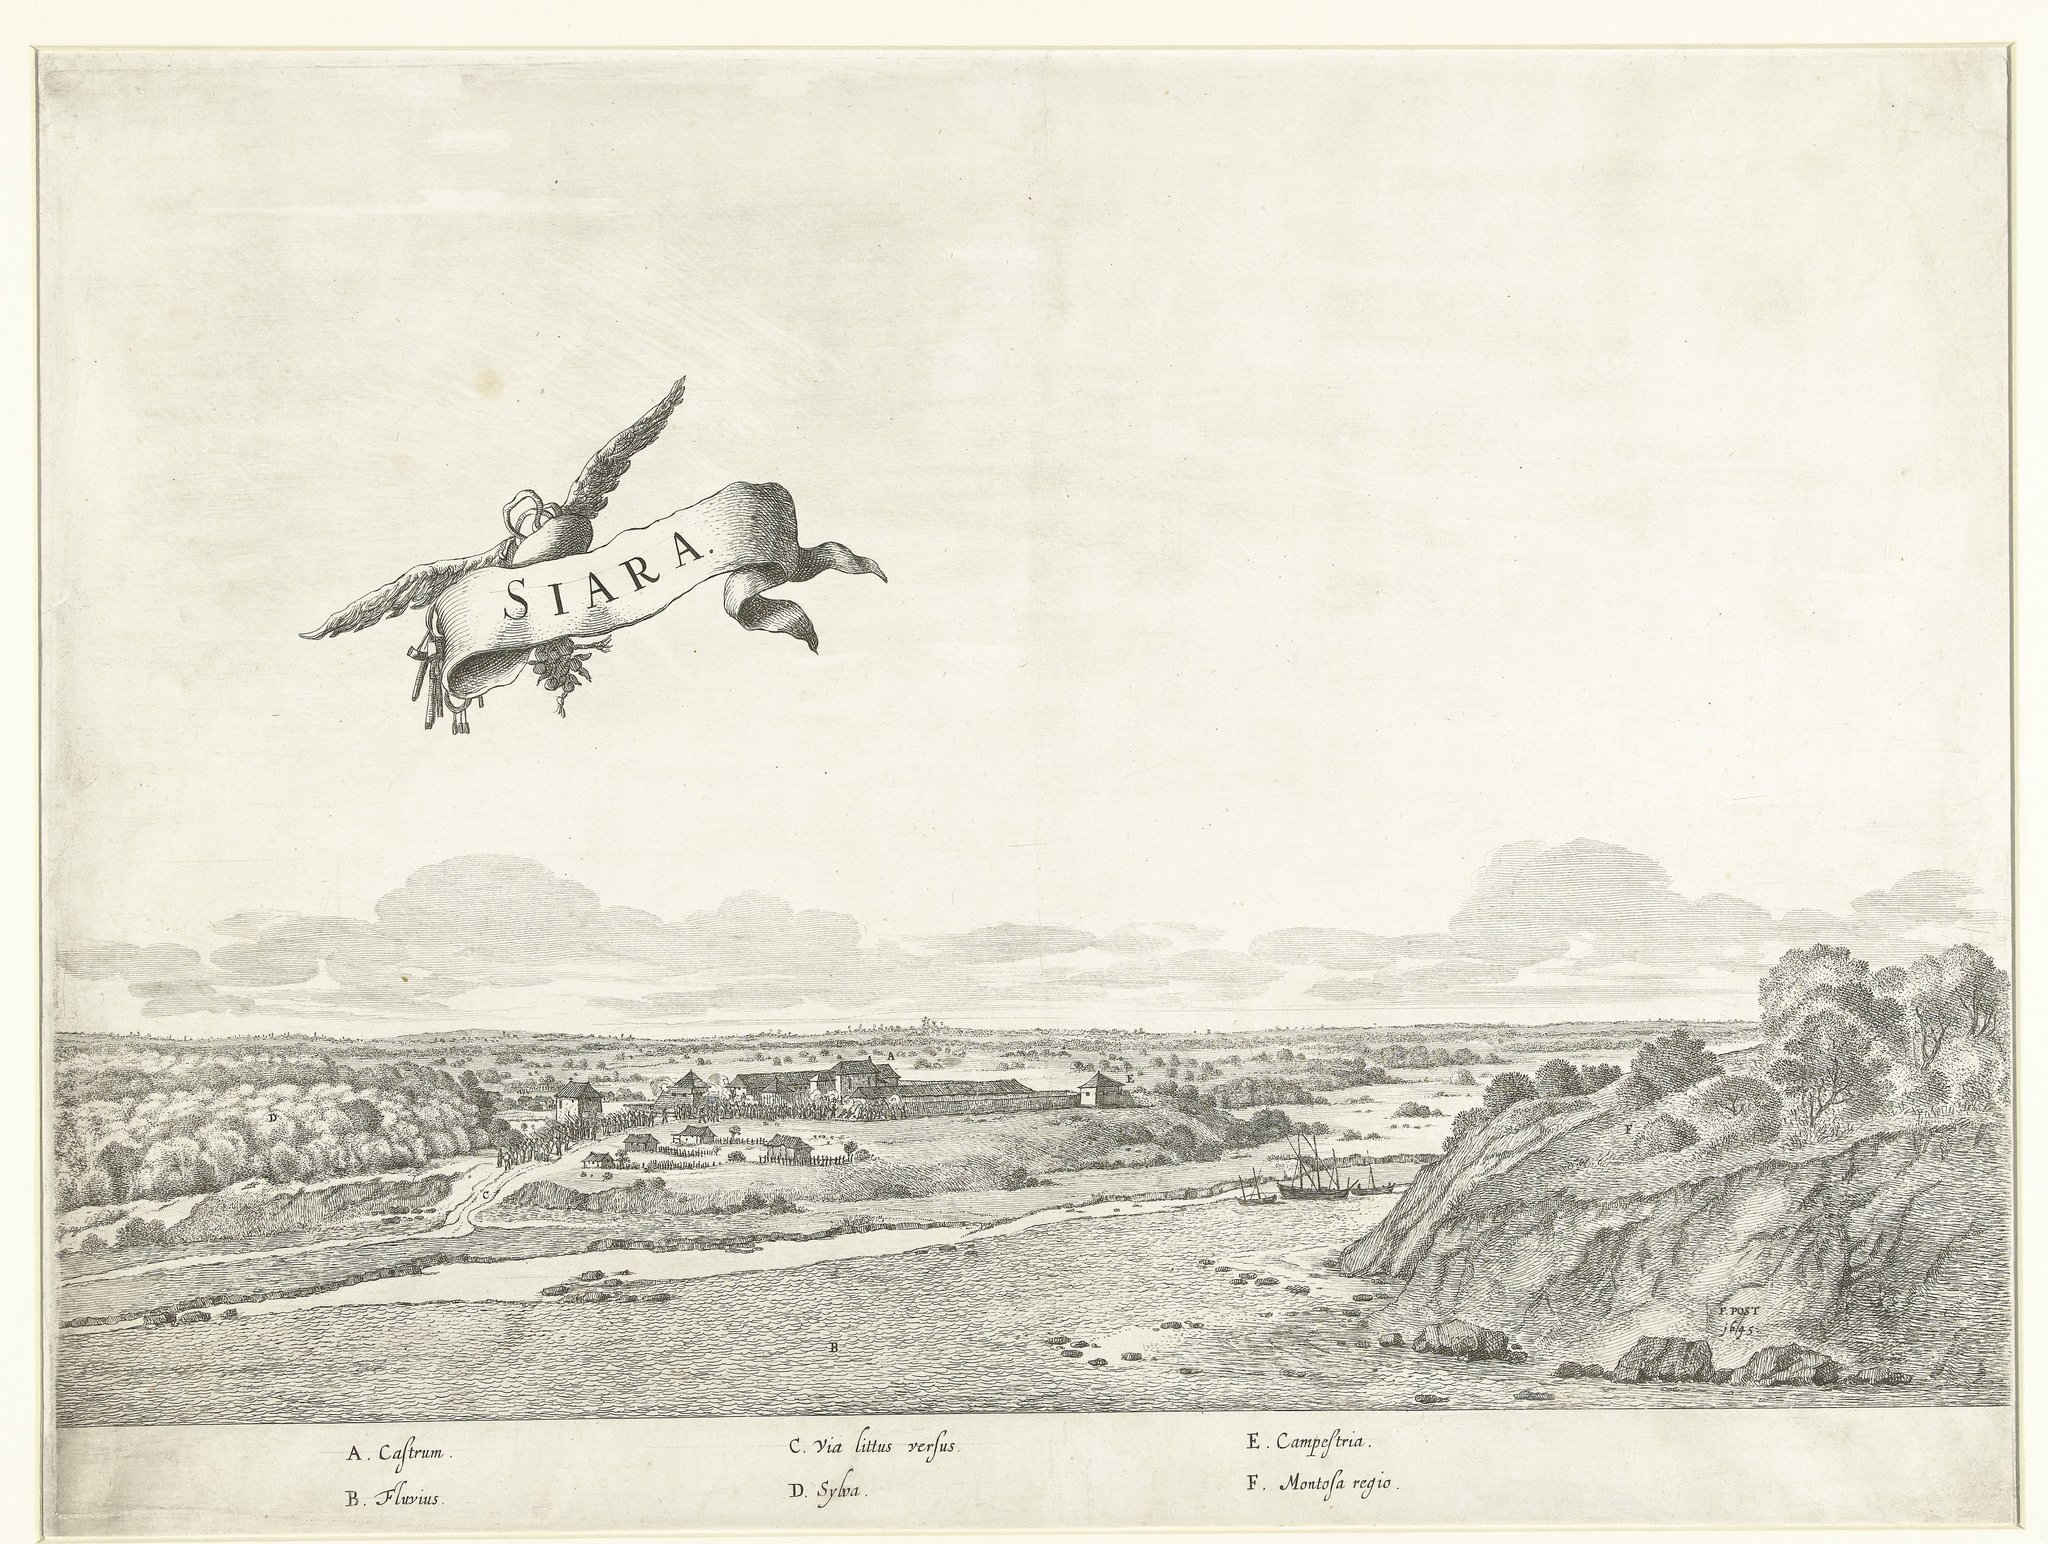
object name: print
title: Gezicht op Siara, ca. 1636-1644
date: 1645-1647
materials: paper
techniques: engraving, etching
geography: netherlands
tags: earl, johan maurits graaf van nassau-siegen, fortress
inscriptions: collector's mark: Lugt 2228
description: Prent gebruikt voor: Caspar Barlaeus, Rerum per octennium in Brasilia et alibi nuper gestarum sub praefectura J. Mauritii, Nassoviae, c. comitis... historia, Amsterdam, uitgever Joannes Blaeu, 1647, na p. 66, pl. 24